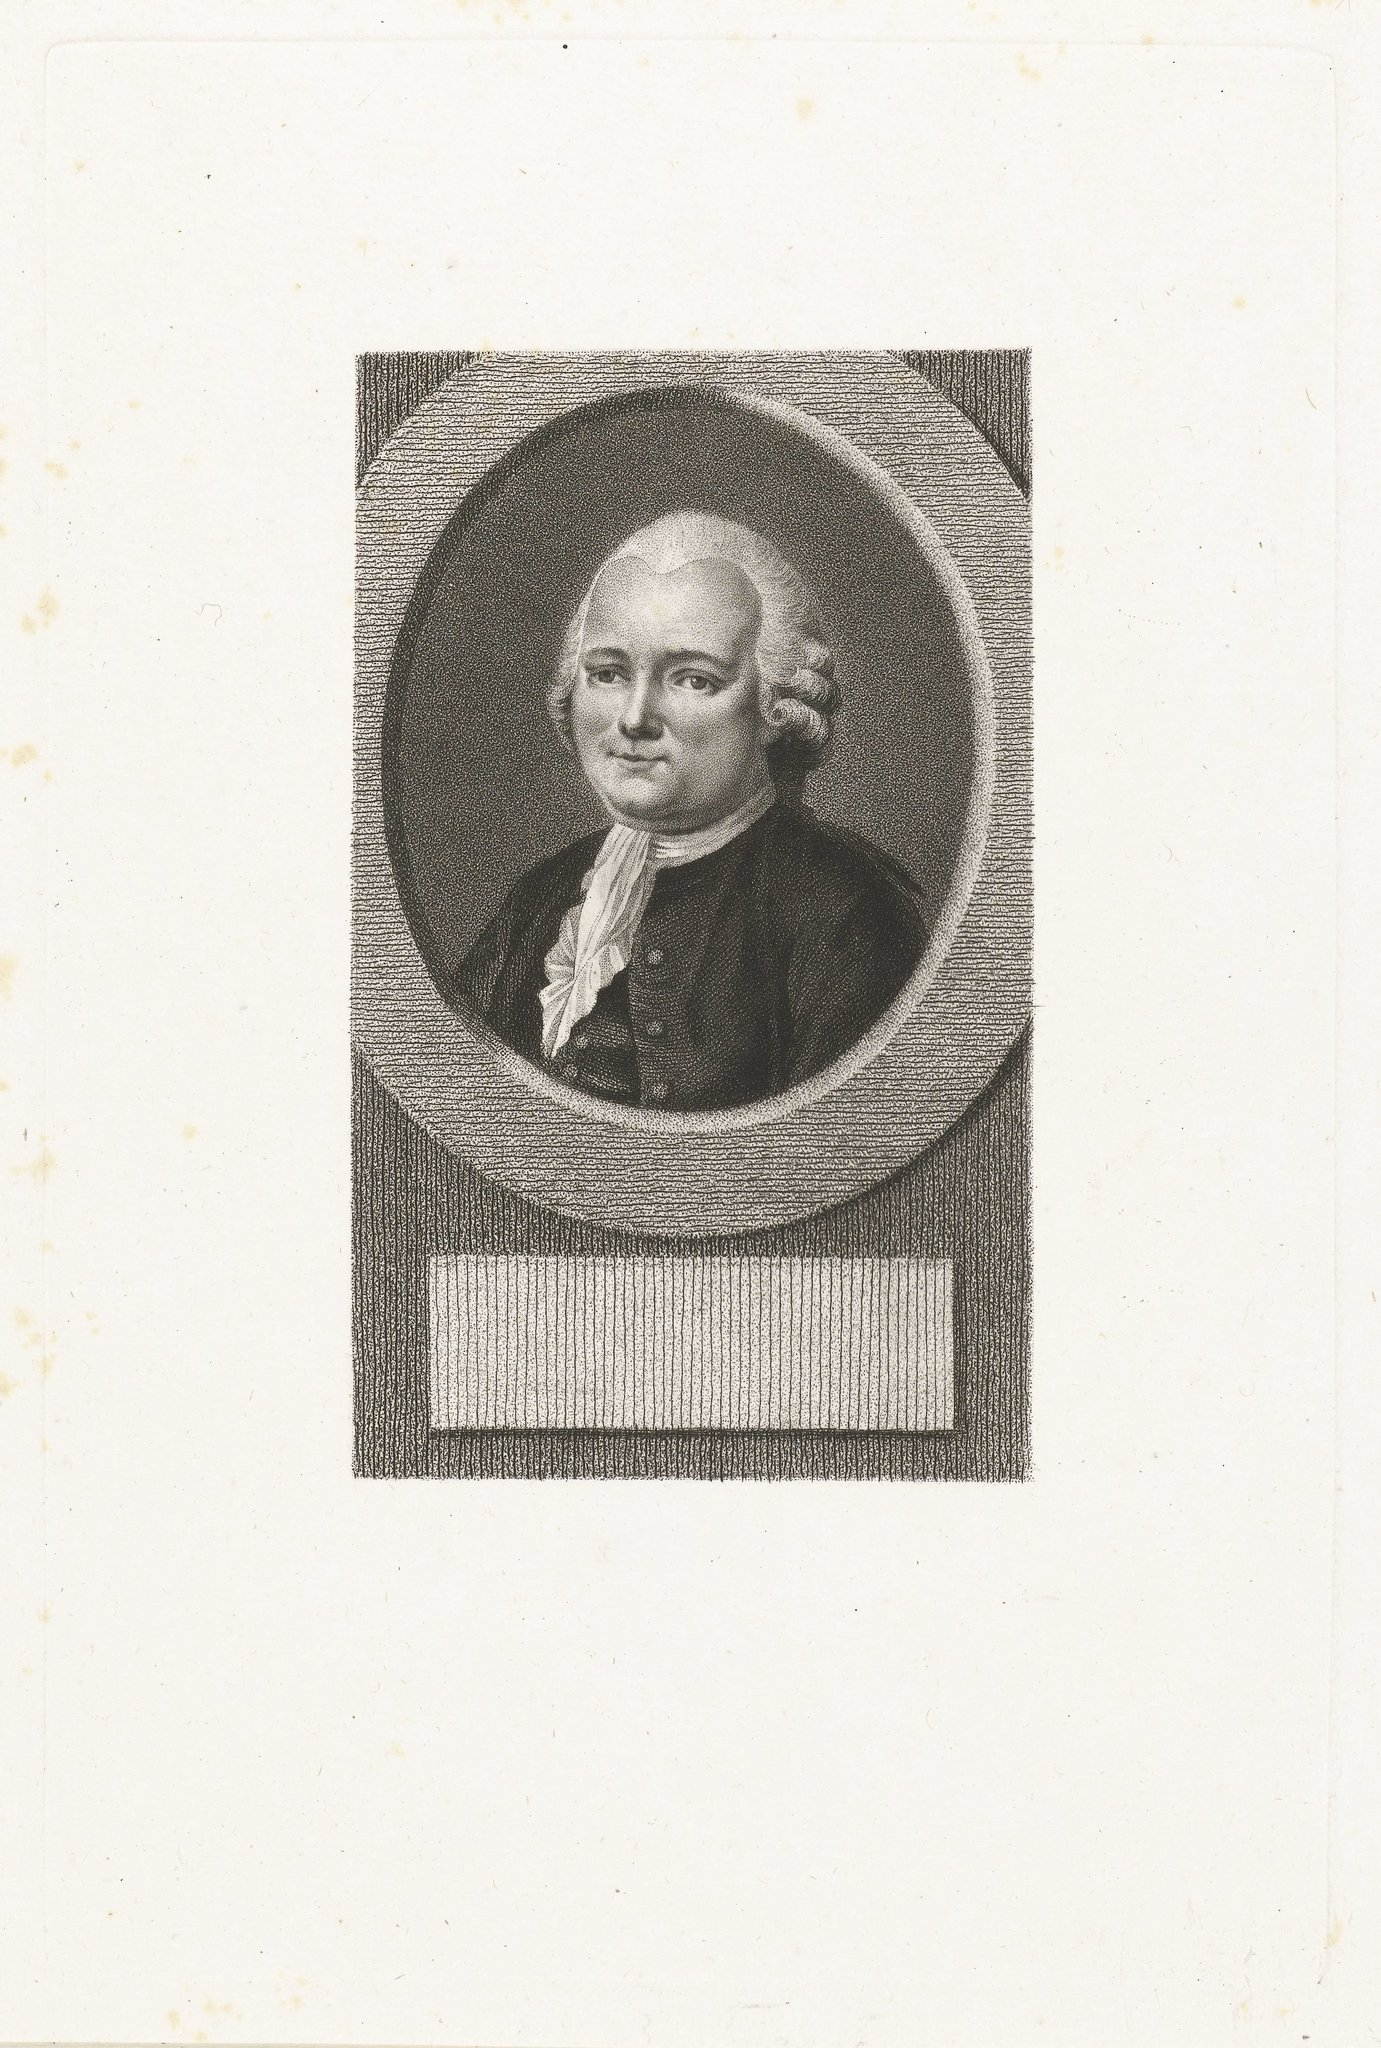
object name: print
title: Portret van Guy-Jean-Baptiste Target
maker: lambertus antonius claessens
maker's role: draughtsman, print maker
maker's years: 1763-1834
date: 1792-1808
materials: paper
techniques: engraving, etching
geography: amsterdam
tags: politician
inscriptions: collector's mark: Lugt 2228